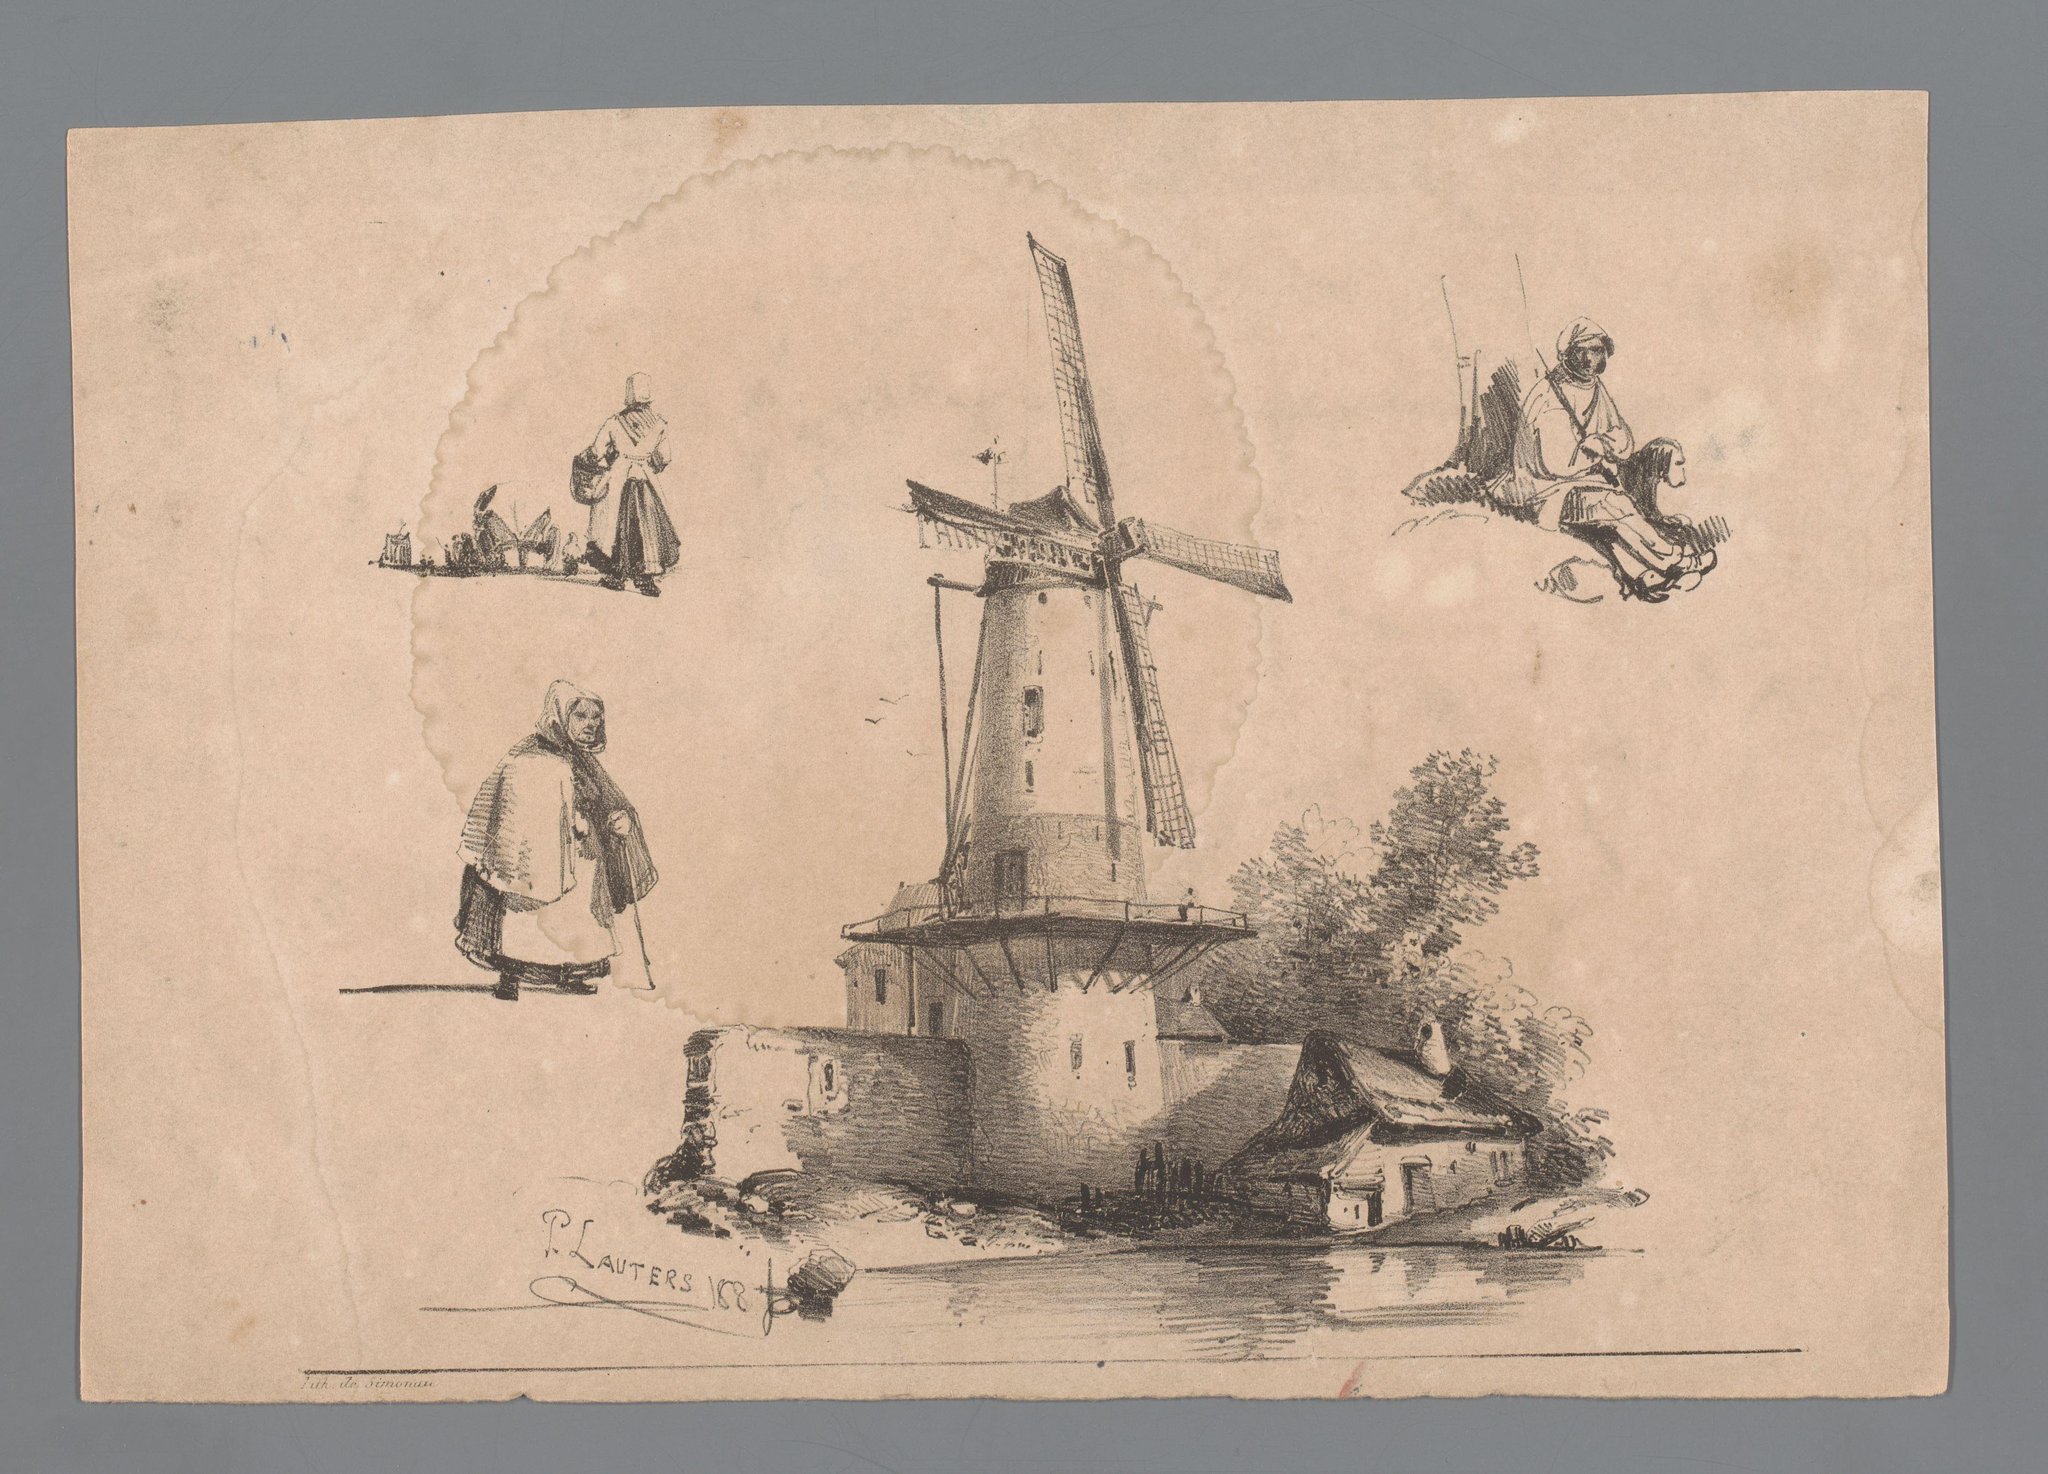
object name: print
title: Molen aan het water met rondom drie figuurstudies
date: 1828-1849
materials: paper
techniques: lithograph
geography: brussels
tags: walking-stick, staff, adult man, old woman, windmill, dog